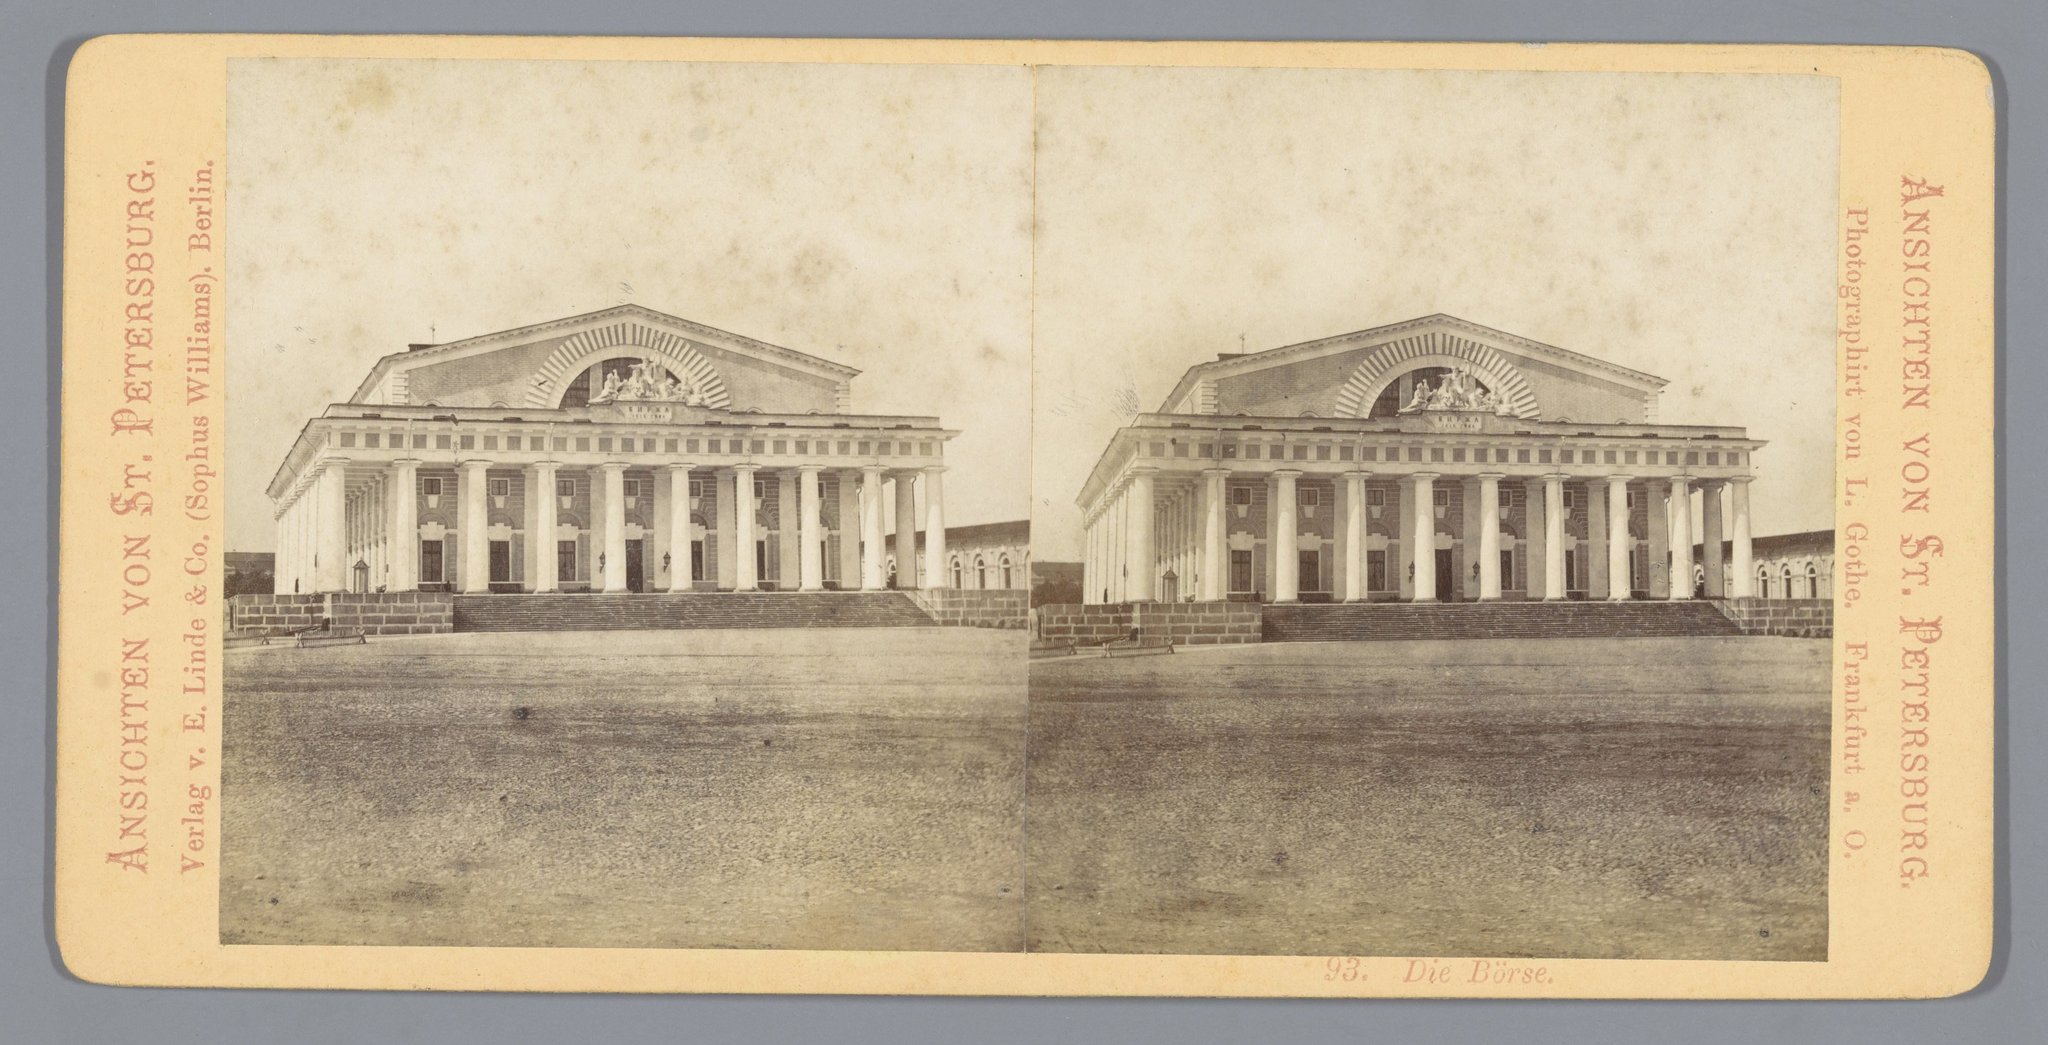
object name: stereograph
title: Die Börse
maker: louis gothe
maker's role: fotograaf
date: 1850-1880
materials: cardboard, photographic support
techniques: albumen print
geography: berlin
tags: stock exchange, stock-market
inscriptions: inscription: ‘Ansichten von St. Petersburg.’, number: ‘93.’